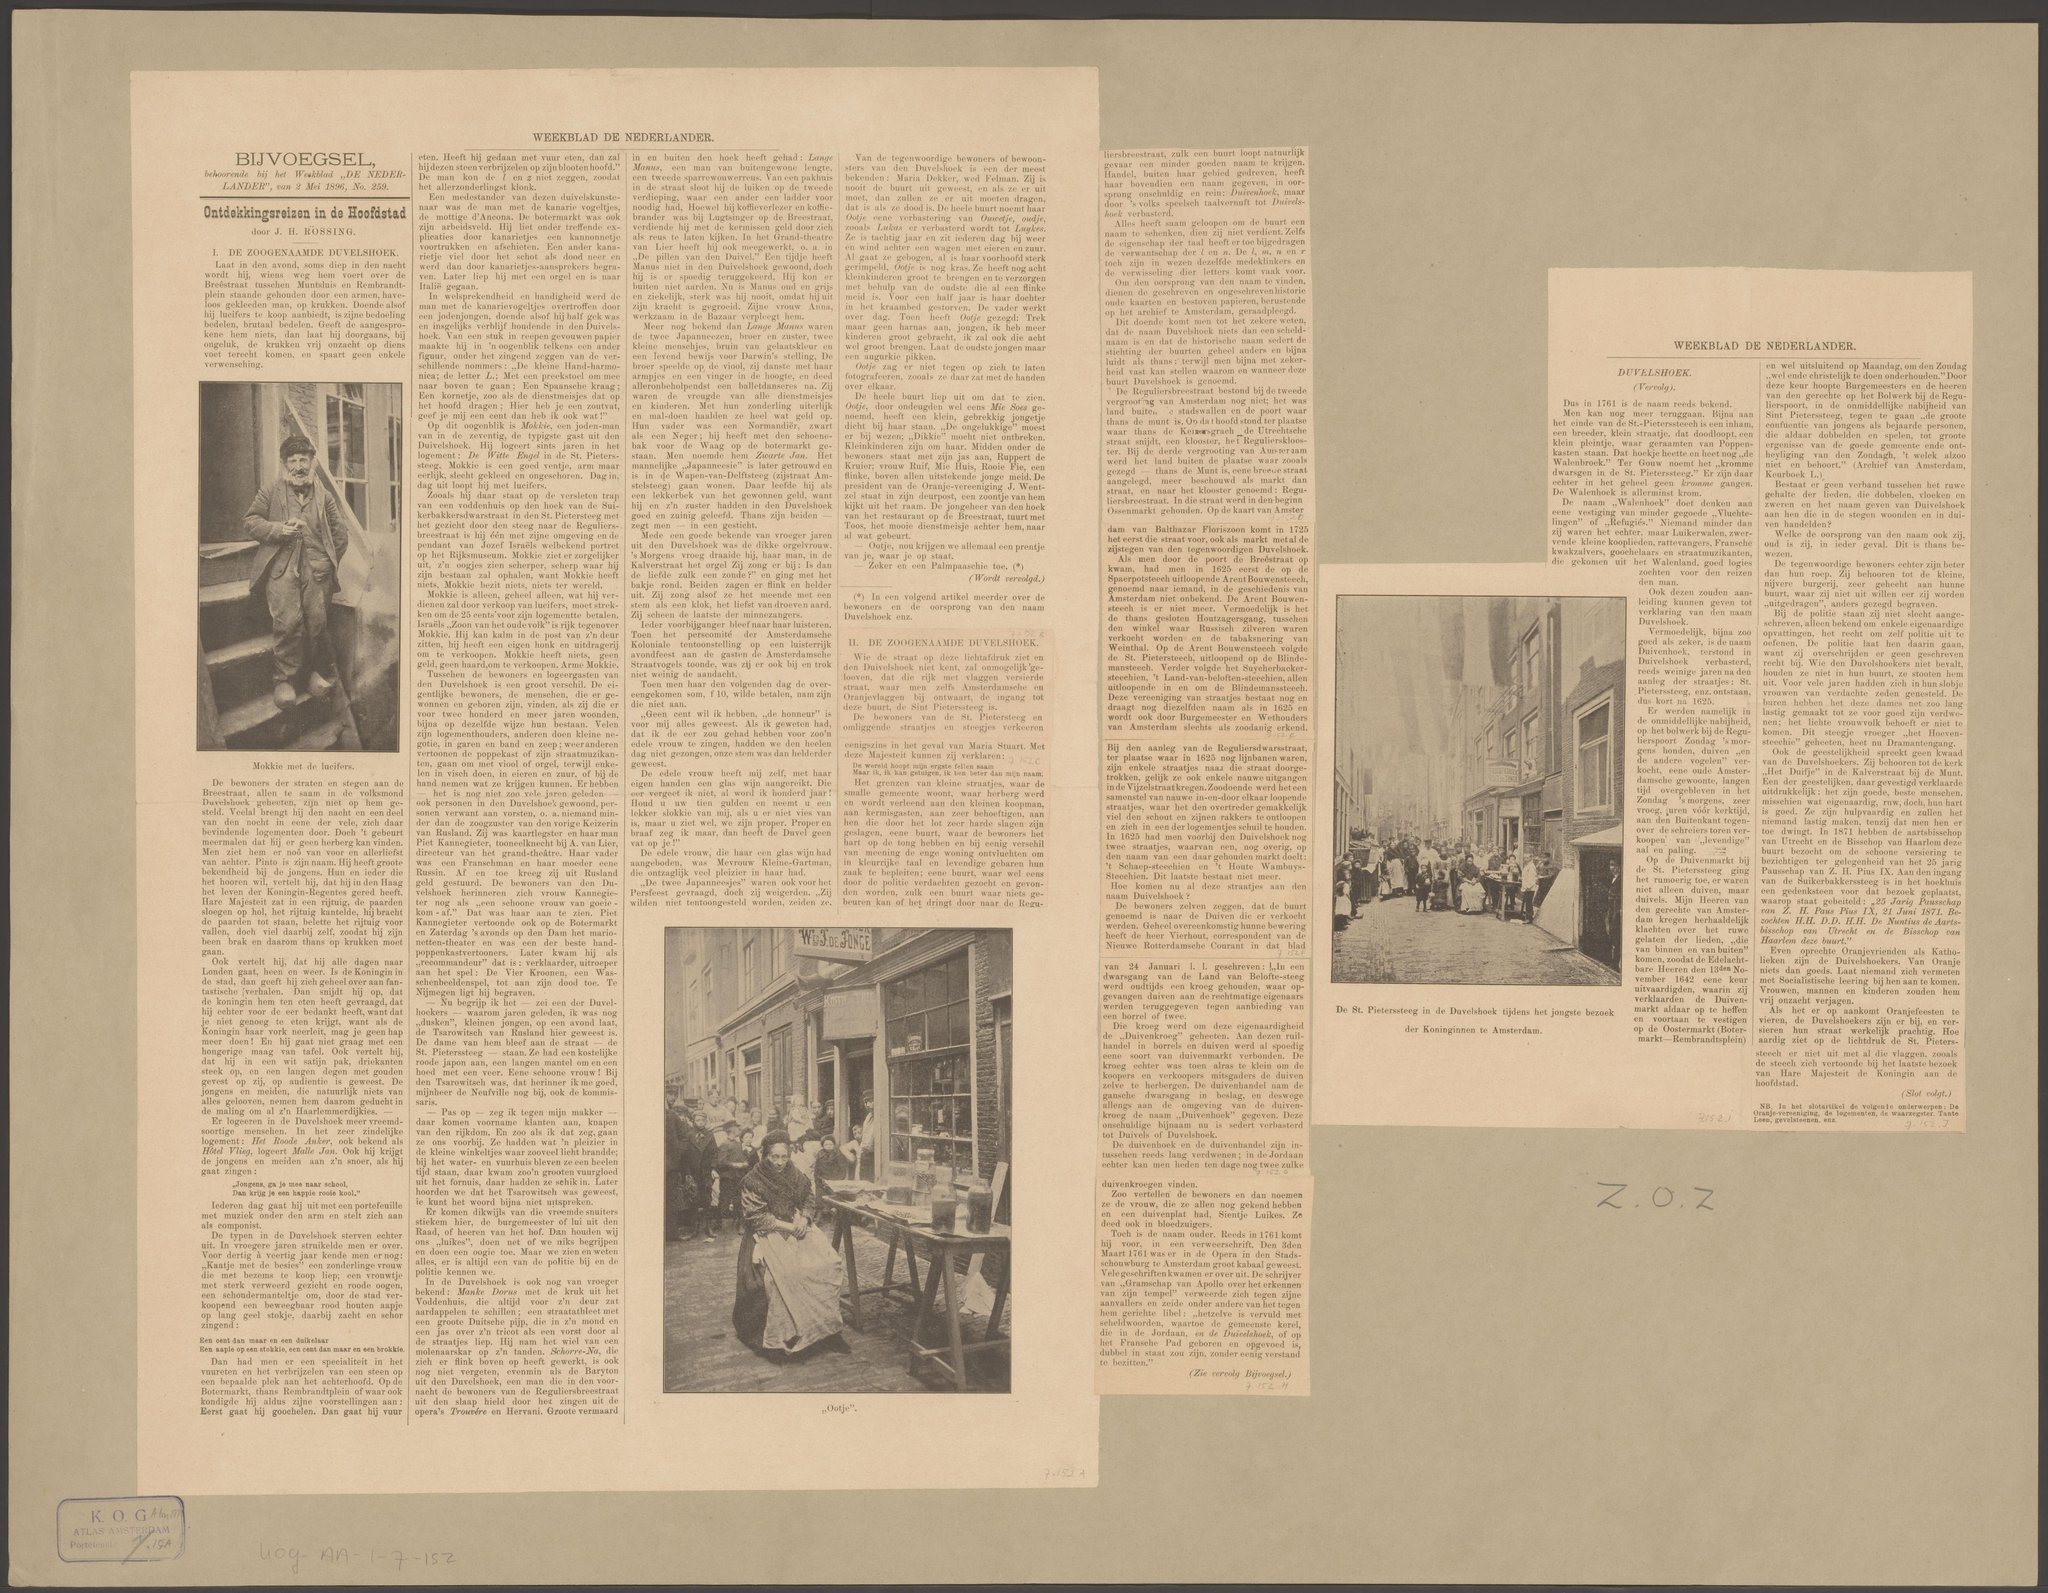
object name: newspaper clipping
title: Teksten over de Duvelshoek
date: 1896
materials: paper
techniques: letterpress printing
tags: the usual house or row of houses, street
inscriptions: collector's mark: ‘7’ Lugt 1641b, name: ‘J.H. Rössing’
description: Onderwerpsrubriek binnen de Atlas Amsterdam: Damrak, Damstraat, Doelensluis, Doelenstraat (Nieuwe), Driehoekstraat, Droogbak, Duvelshoek, Dijkstraat en Korte -.